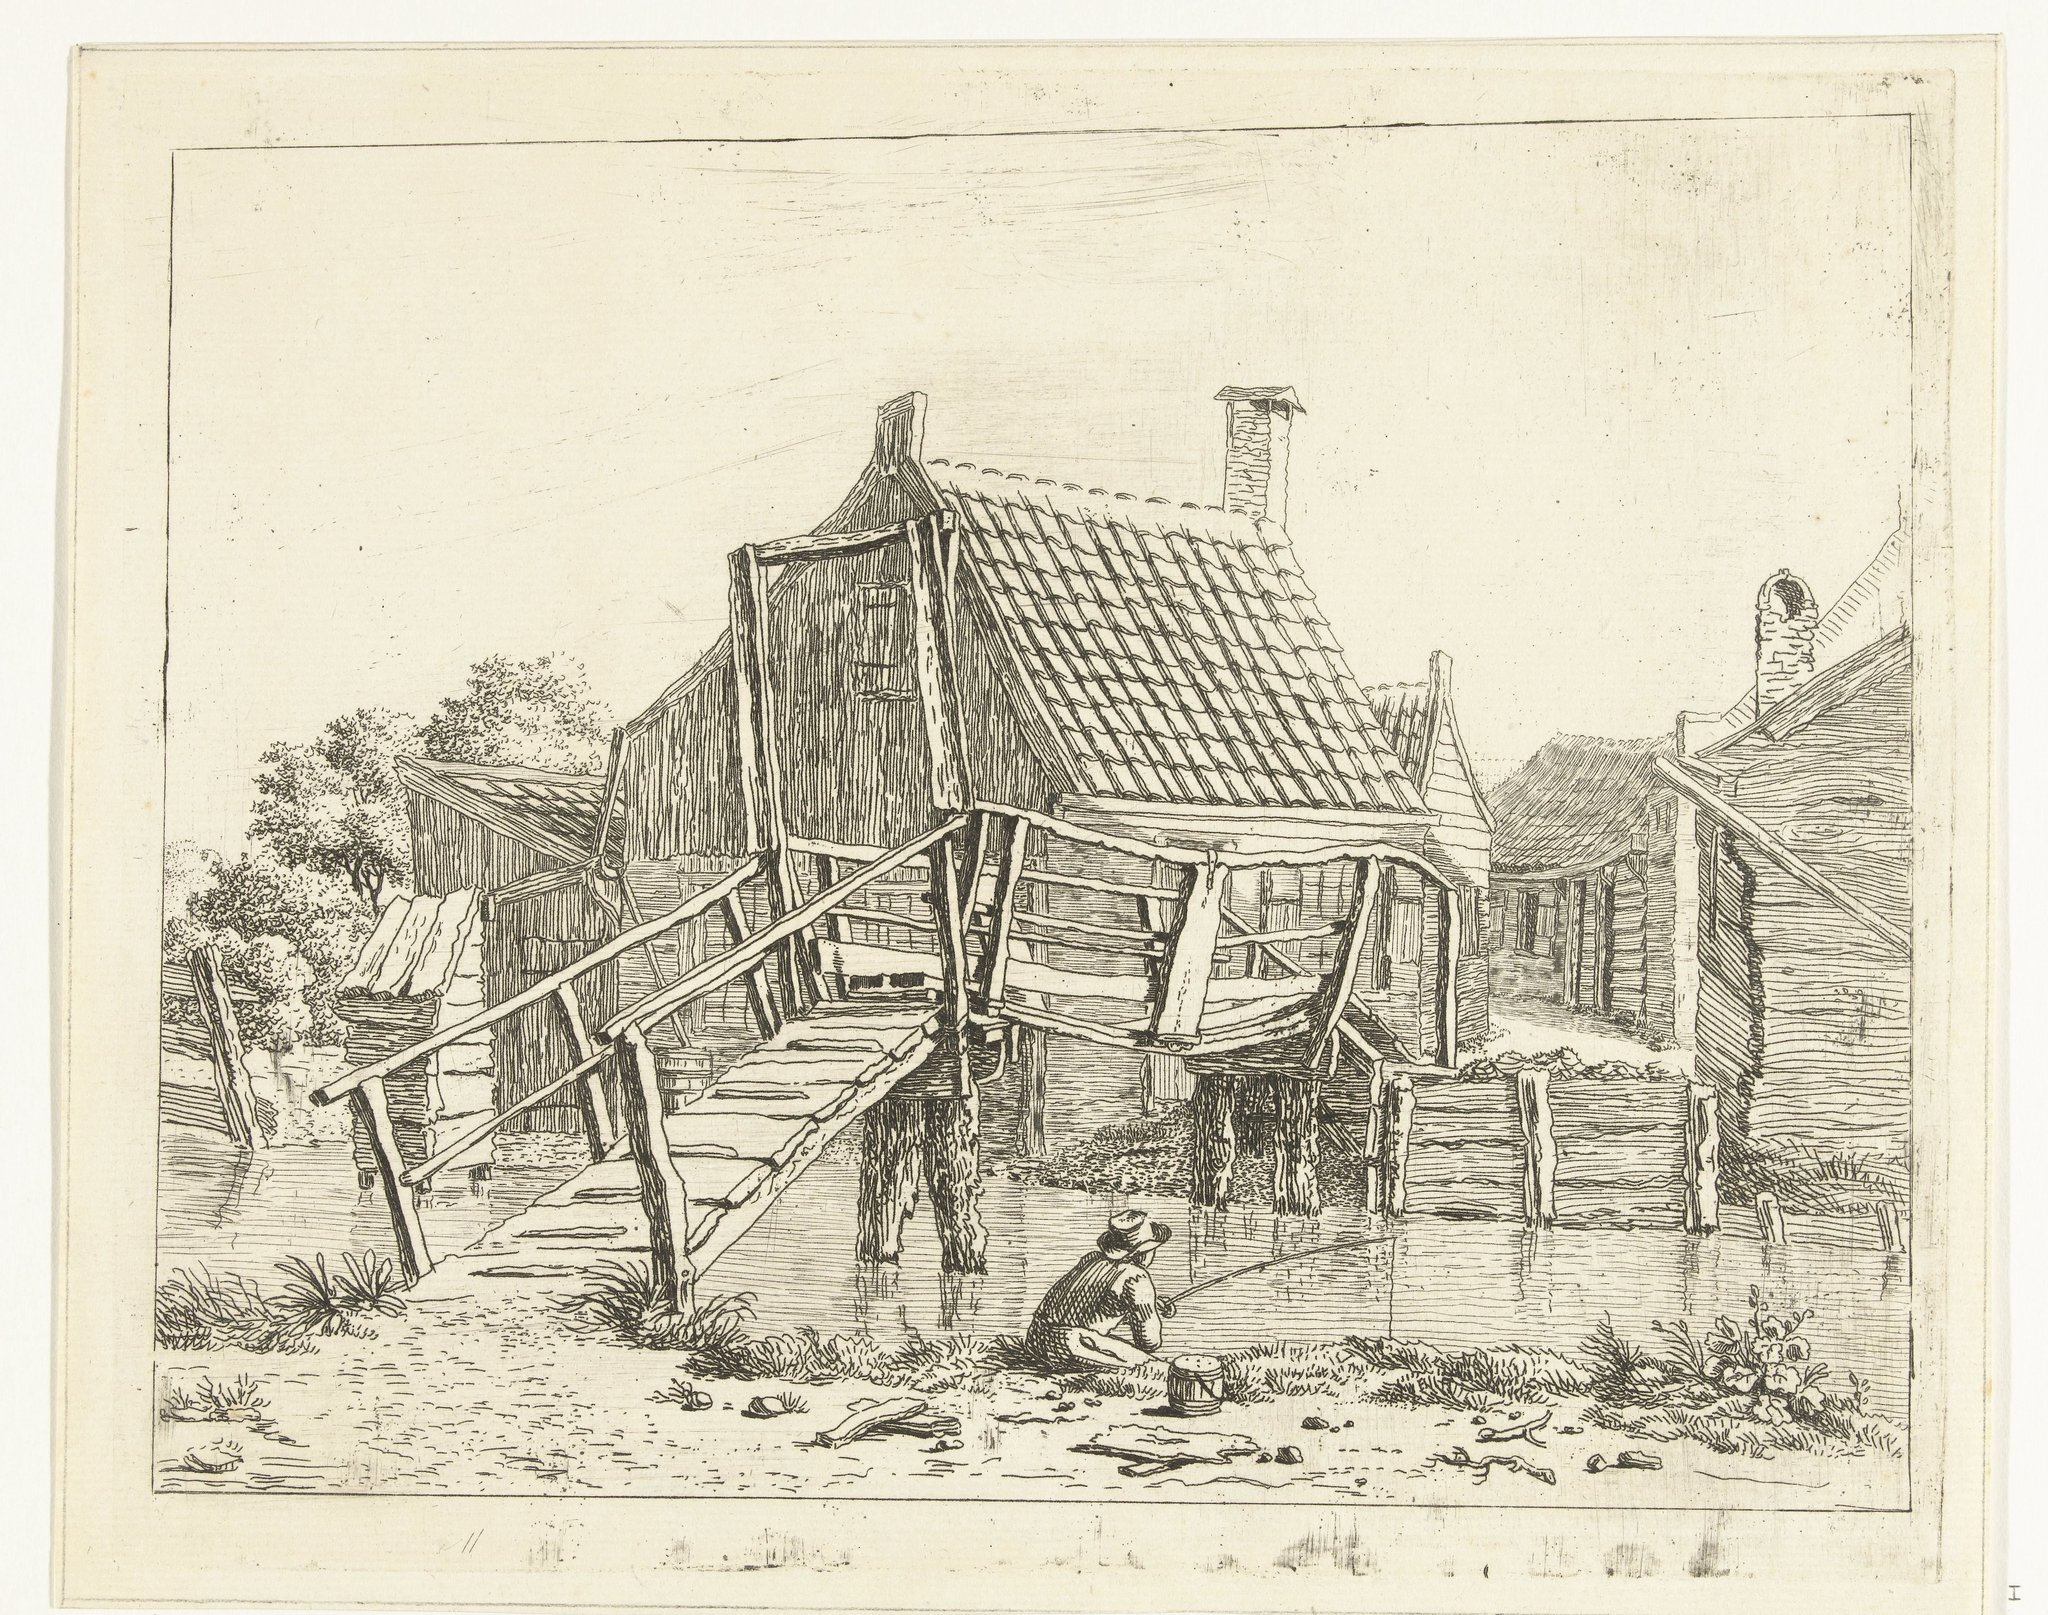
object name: print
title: Buiten de Raampoort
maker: anthonie van den bos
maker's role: draughtsman, print maker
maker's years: 1763-1838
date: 1778-1838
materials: paper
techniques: etching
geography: netherlands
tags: angling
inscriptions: collector's mark: Lugt 2228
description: Een man zit aan de oever van een sloot te hengelen vlakbij een houten brug.